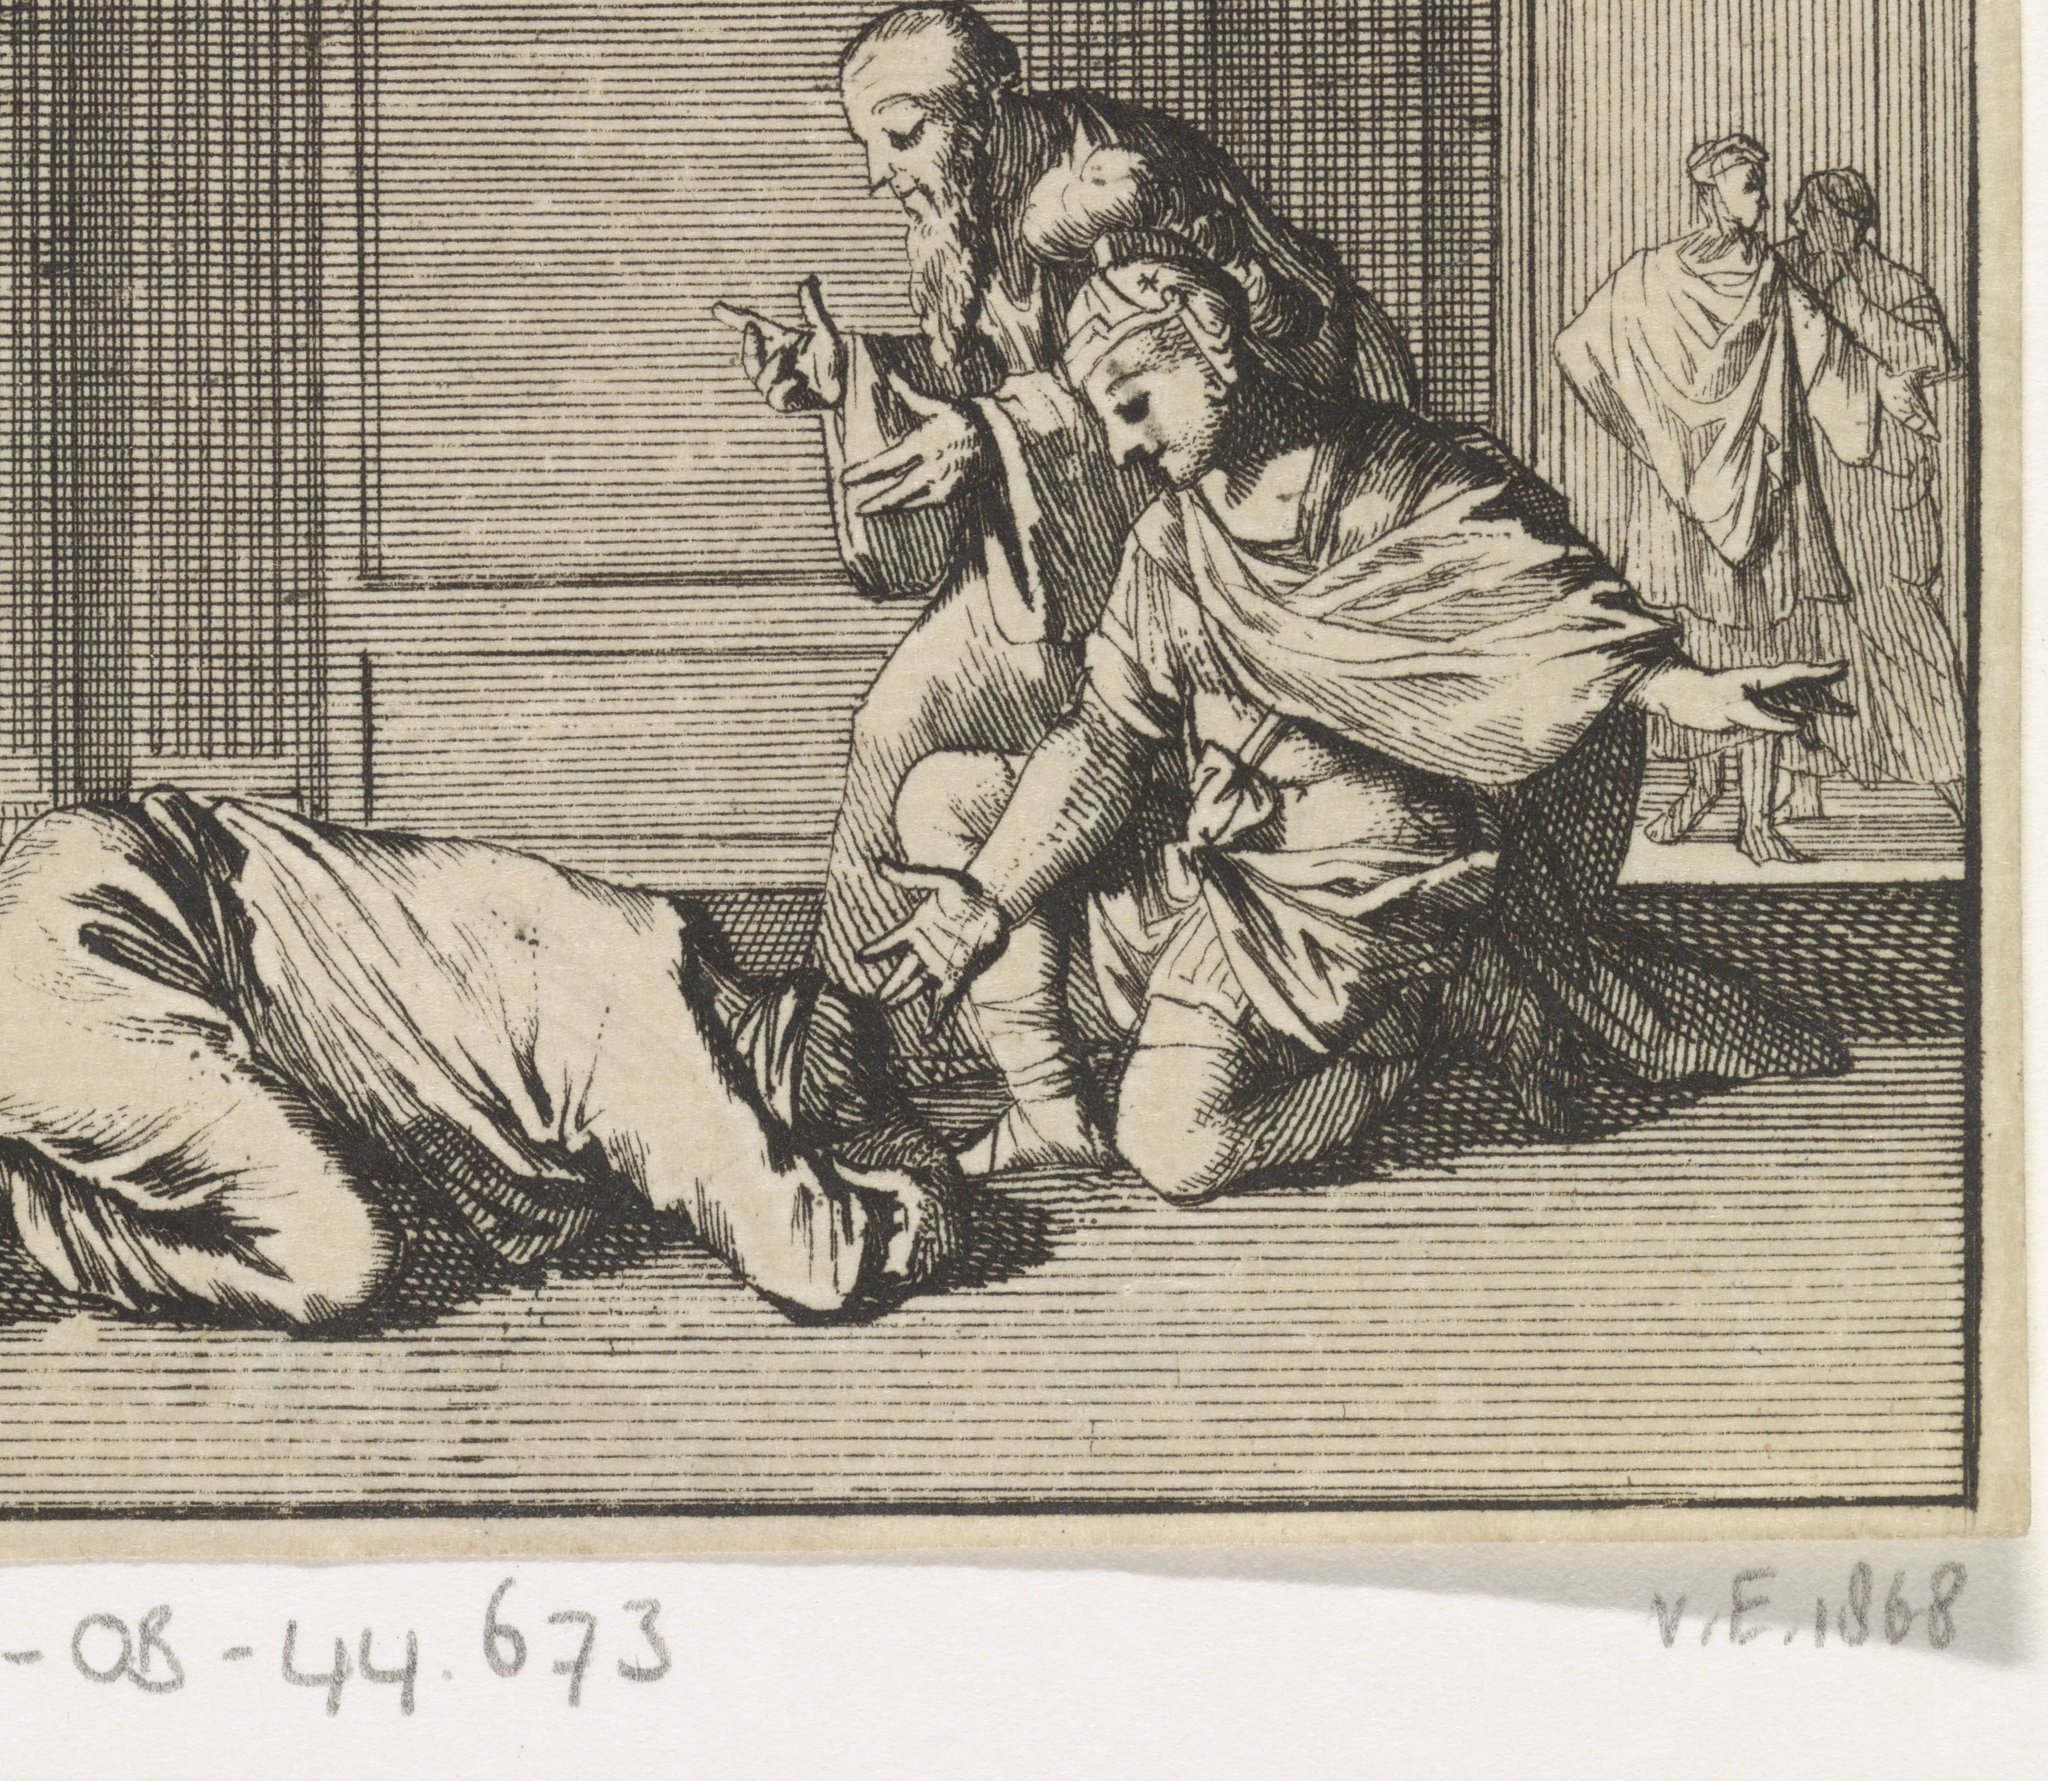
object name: print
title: David bidt voor het leven van het kind van Bathseba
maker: caspar luyken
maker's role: draughtsman, print maker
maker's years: 1672-1708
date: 1698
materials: paper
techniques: etching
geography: amsterdam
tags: david repentant; he lies on the ground praying and fasting for his child to recover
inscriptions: collector's mark: Lugt 2228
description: Proefdruk van illustratie uit: Josephus, Flavius. XX. boeken van de oude geschiedenissen der joden, 4 delen. Amsterdam: Barent Visscher, Willem de Coup, Willem van Lamsveld, Andries van Damme, 1698, dl. I.